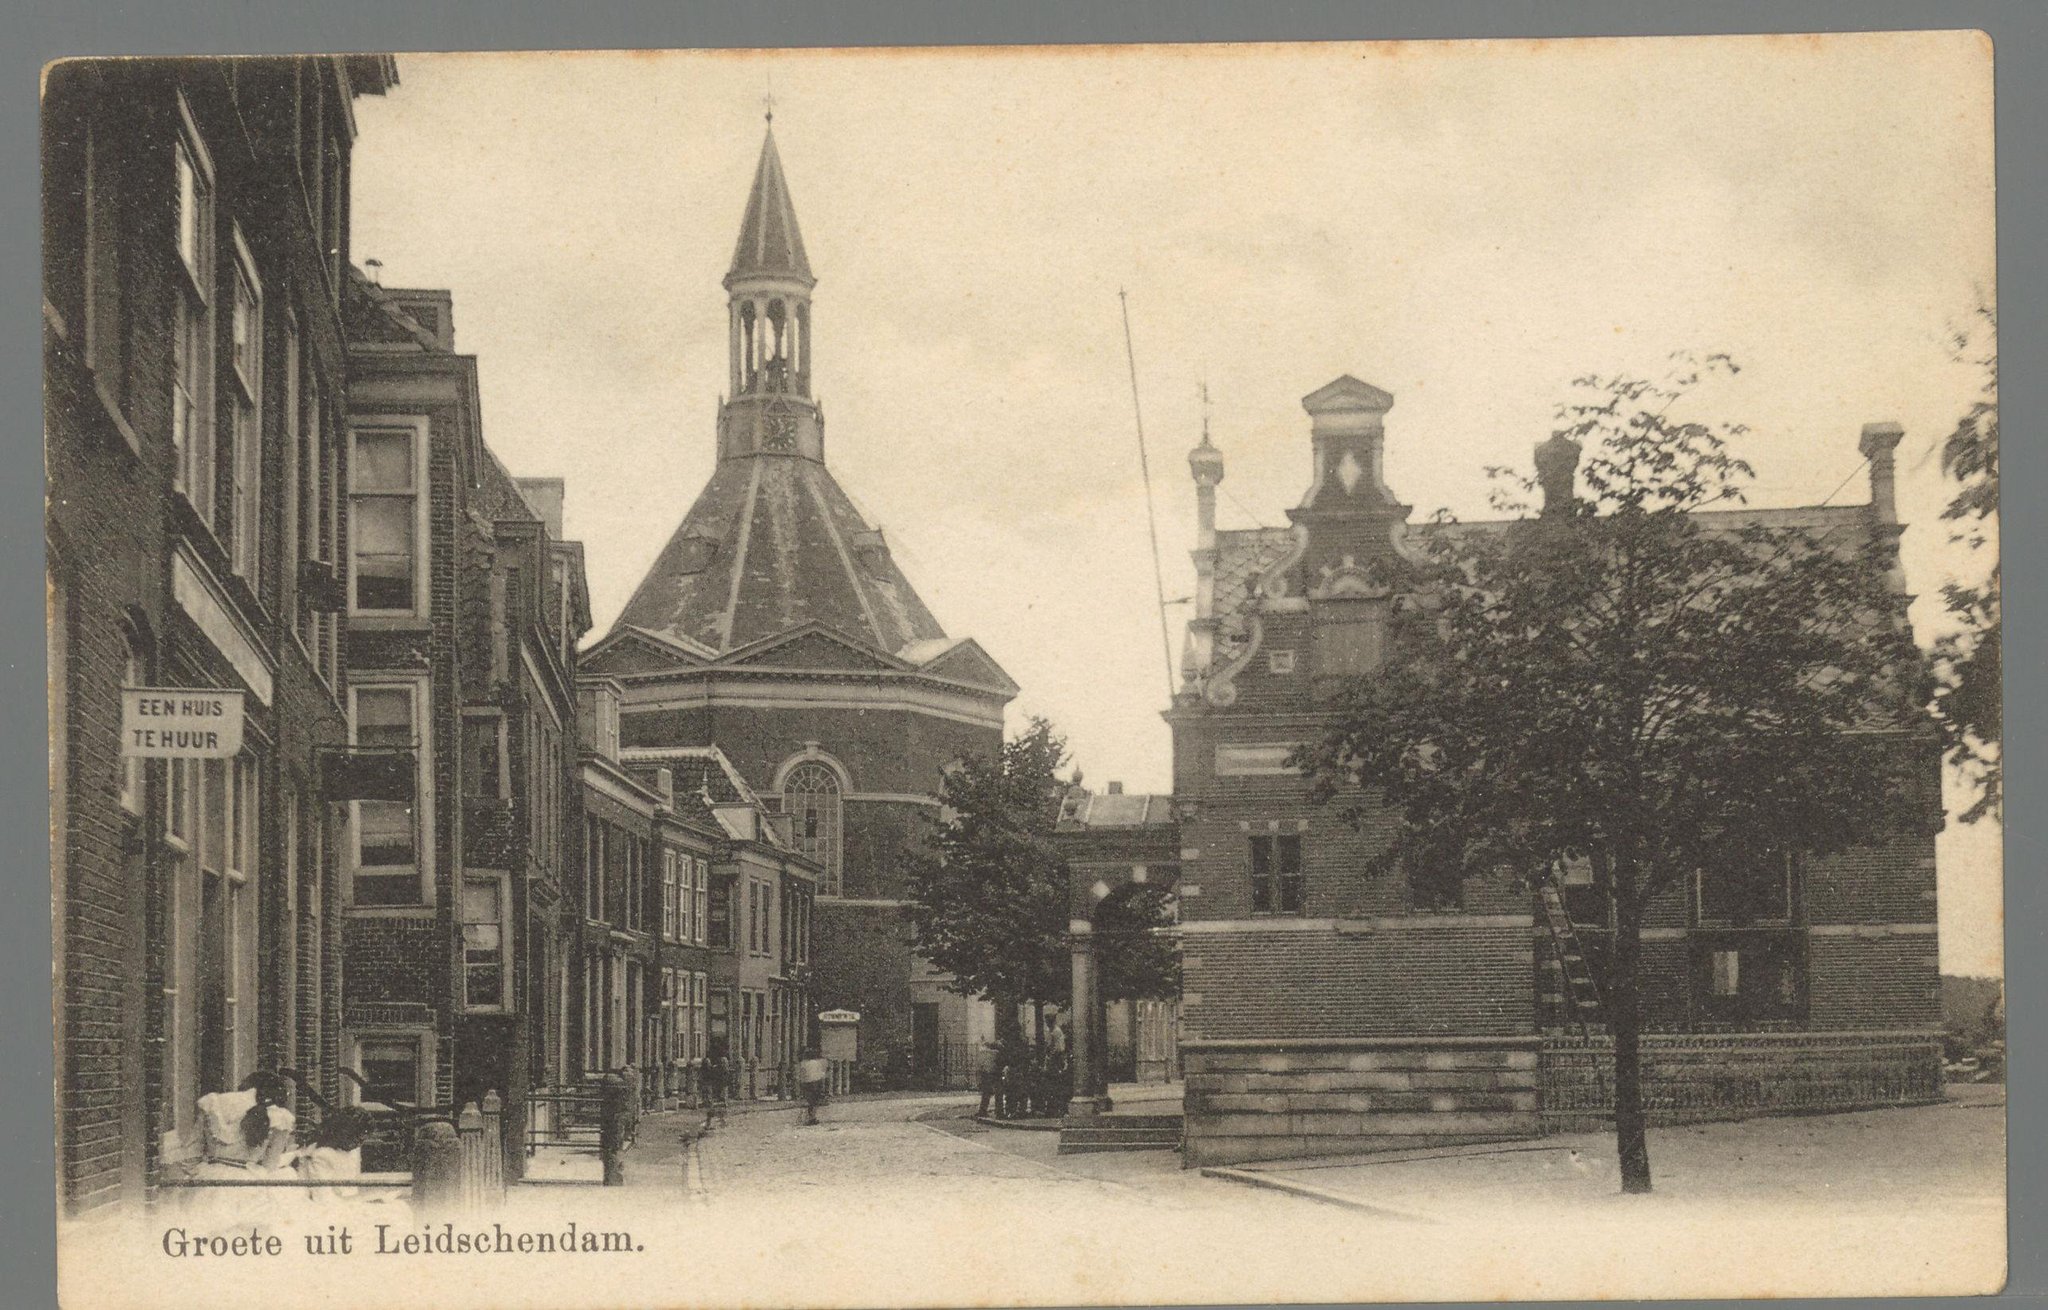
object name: ansichtkaart, prentbriefkaart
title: Groete uit Leidschendam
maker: Anonymous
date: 1892-1905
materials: cardboard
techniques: photograph, writing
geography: leidschendam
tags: church (exterior), street